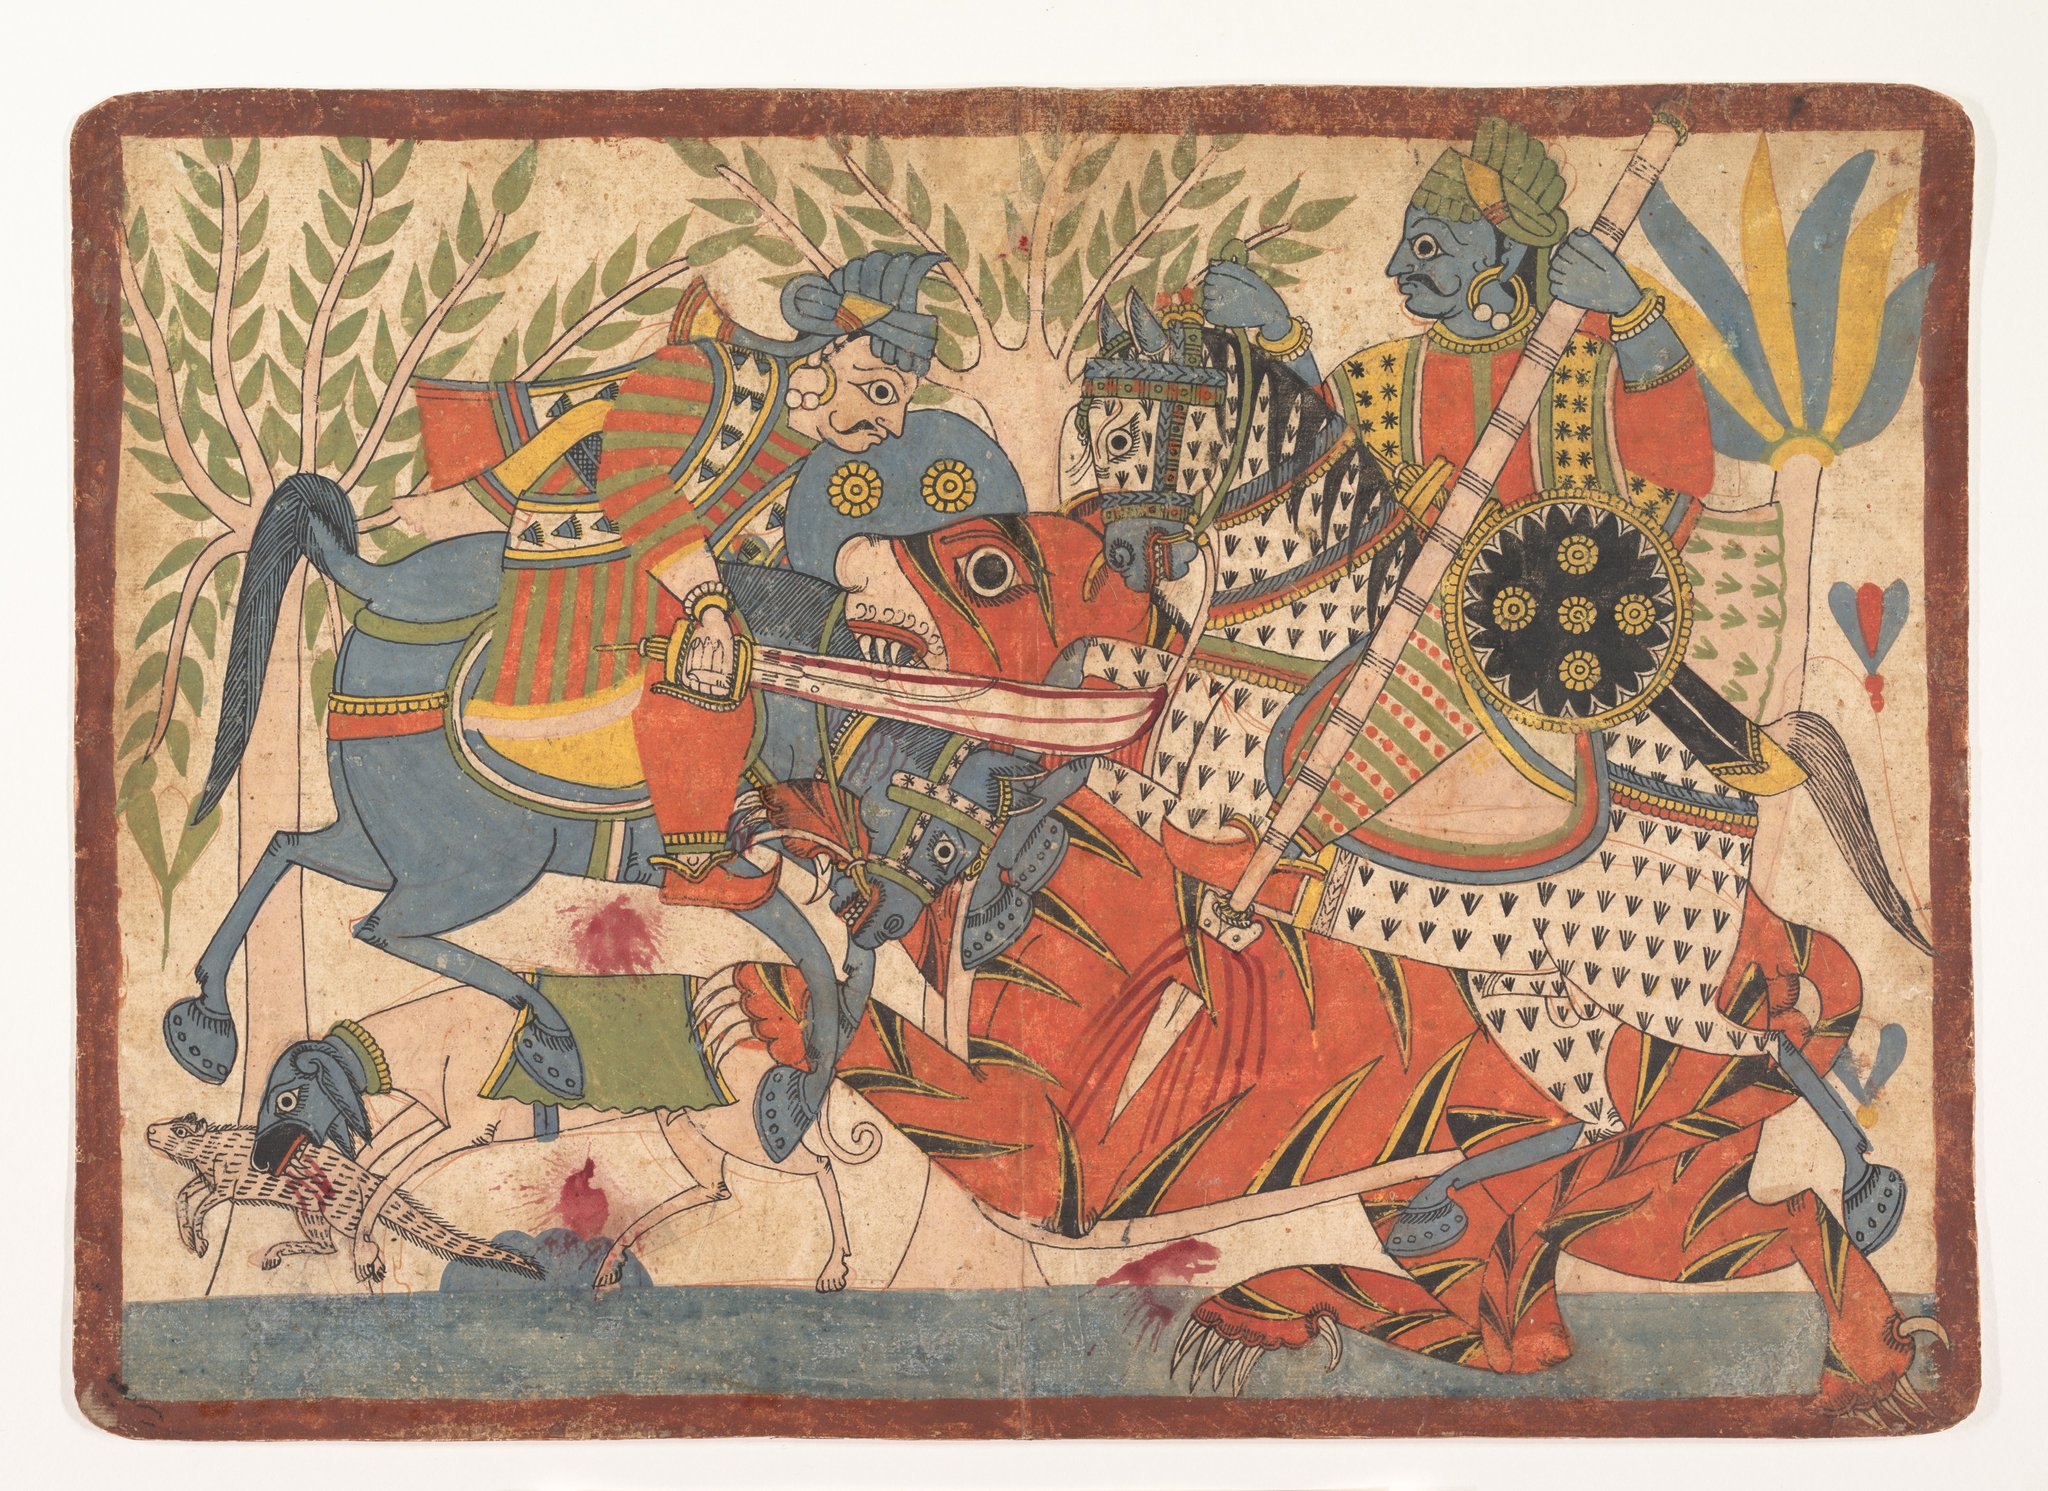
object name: folio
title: “Harishchandra and his Minister Killing a Tiger,” folio from a Harishchandra Series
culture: western indian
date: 1800-1850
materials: ink, paper, watercolor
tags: swords,men,dogs,horses,tigers